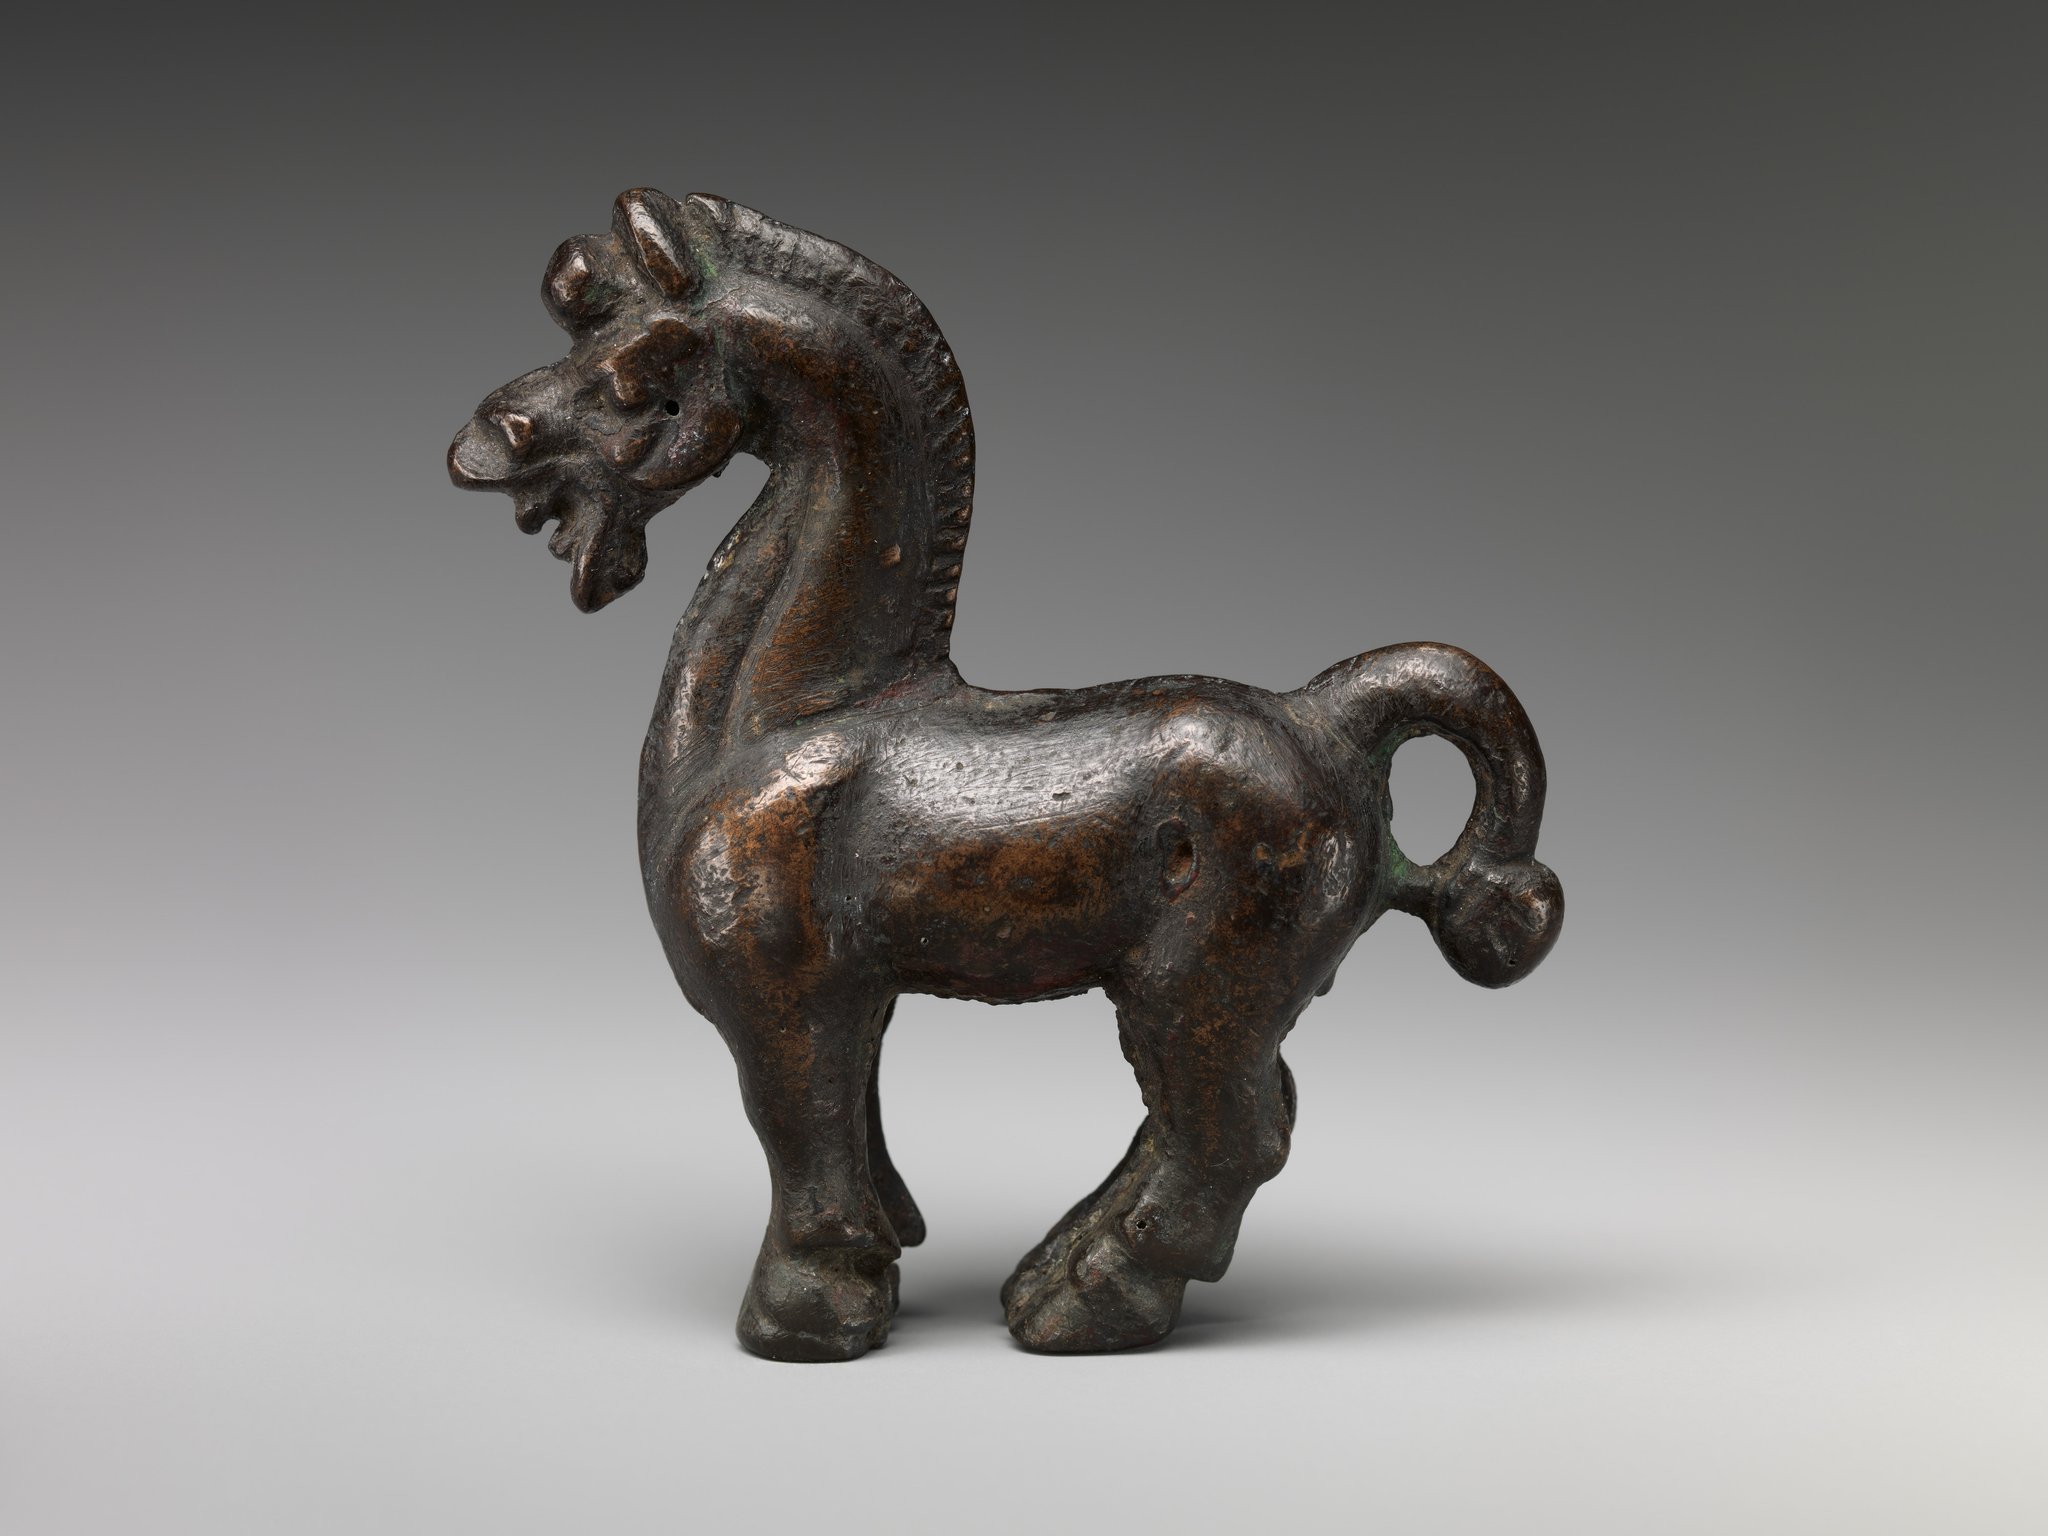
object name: figure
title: Horse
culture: chinese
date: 206 BCE-220 CE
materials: bronze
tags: horses